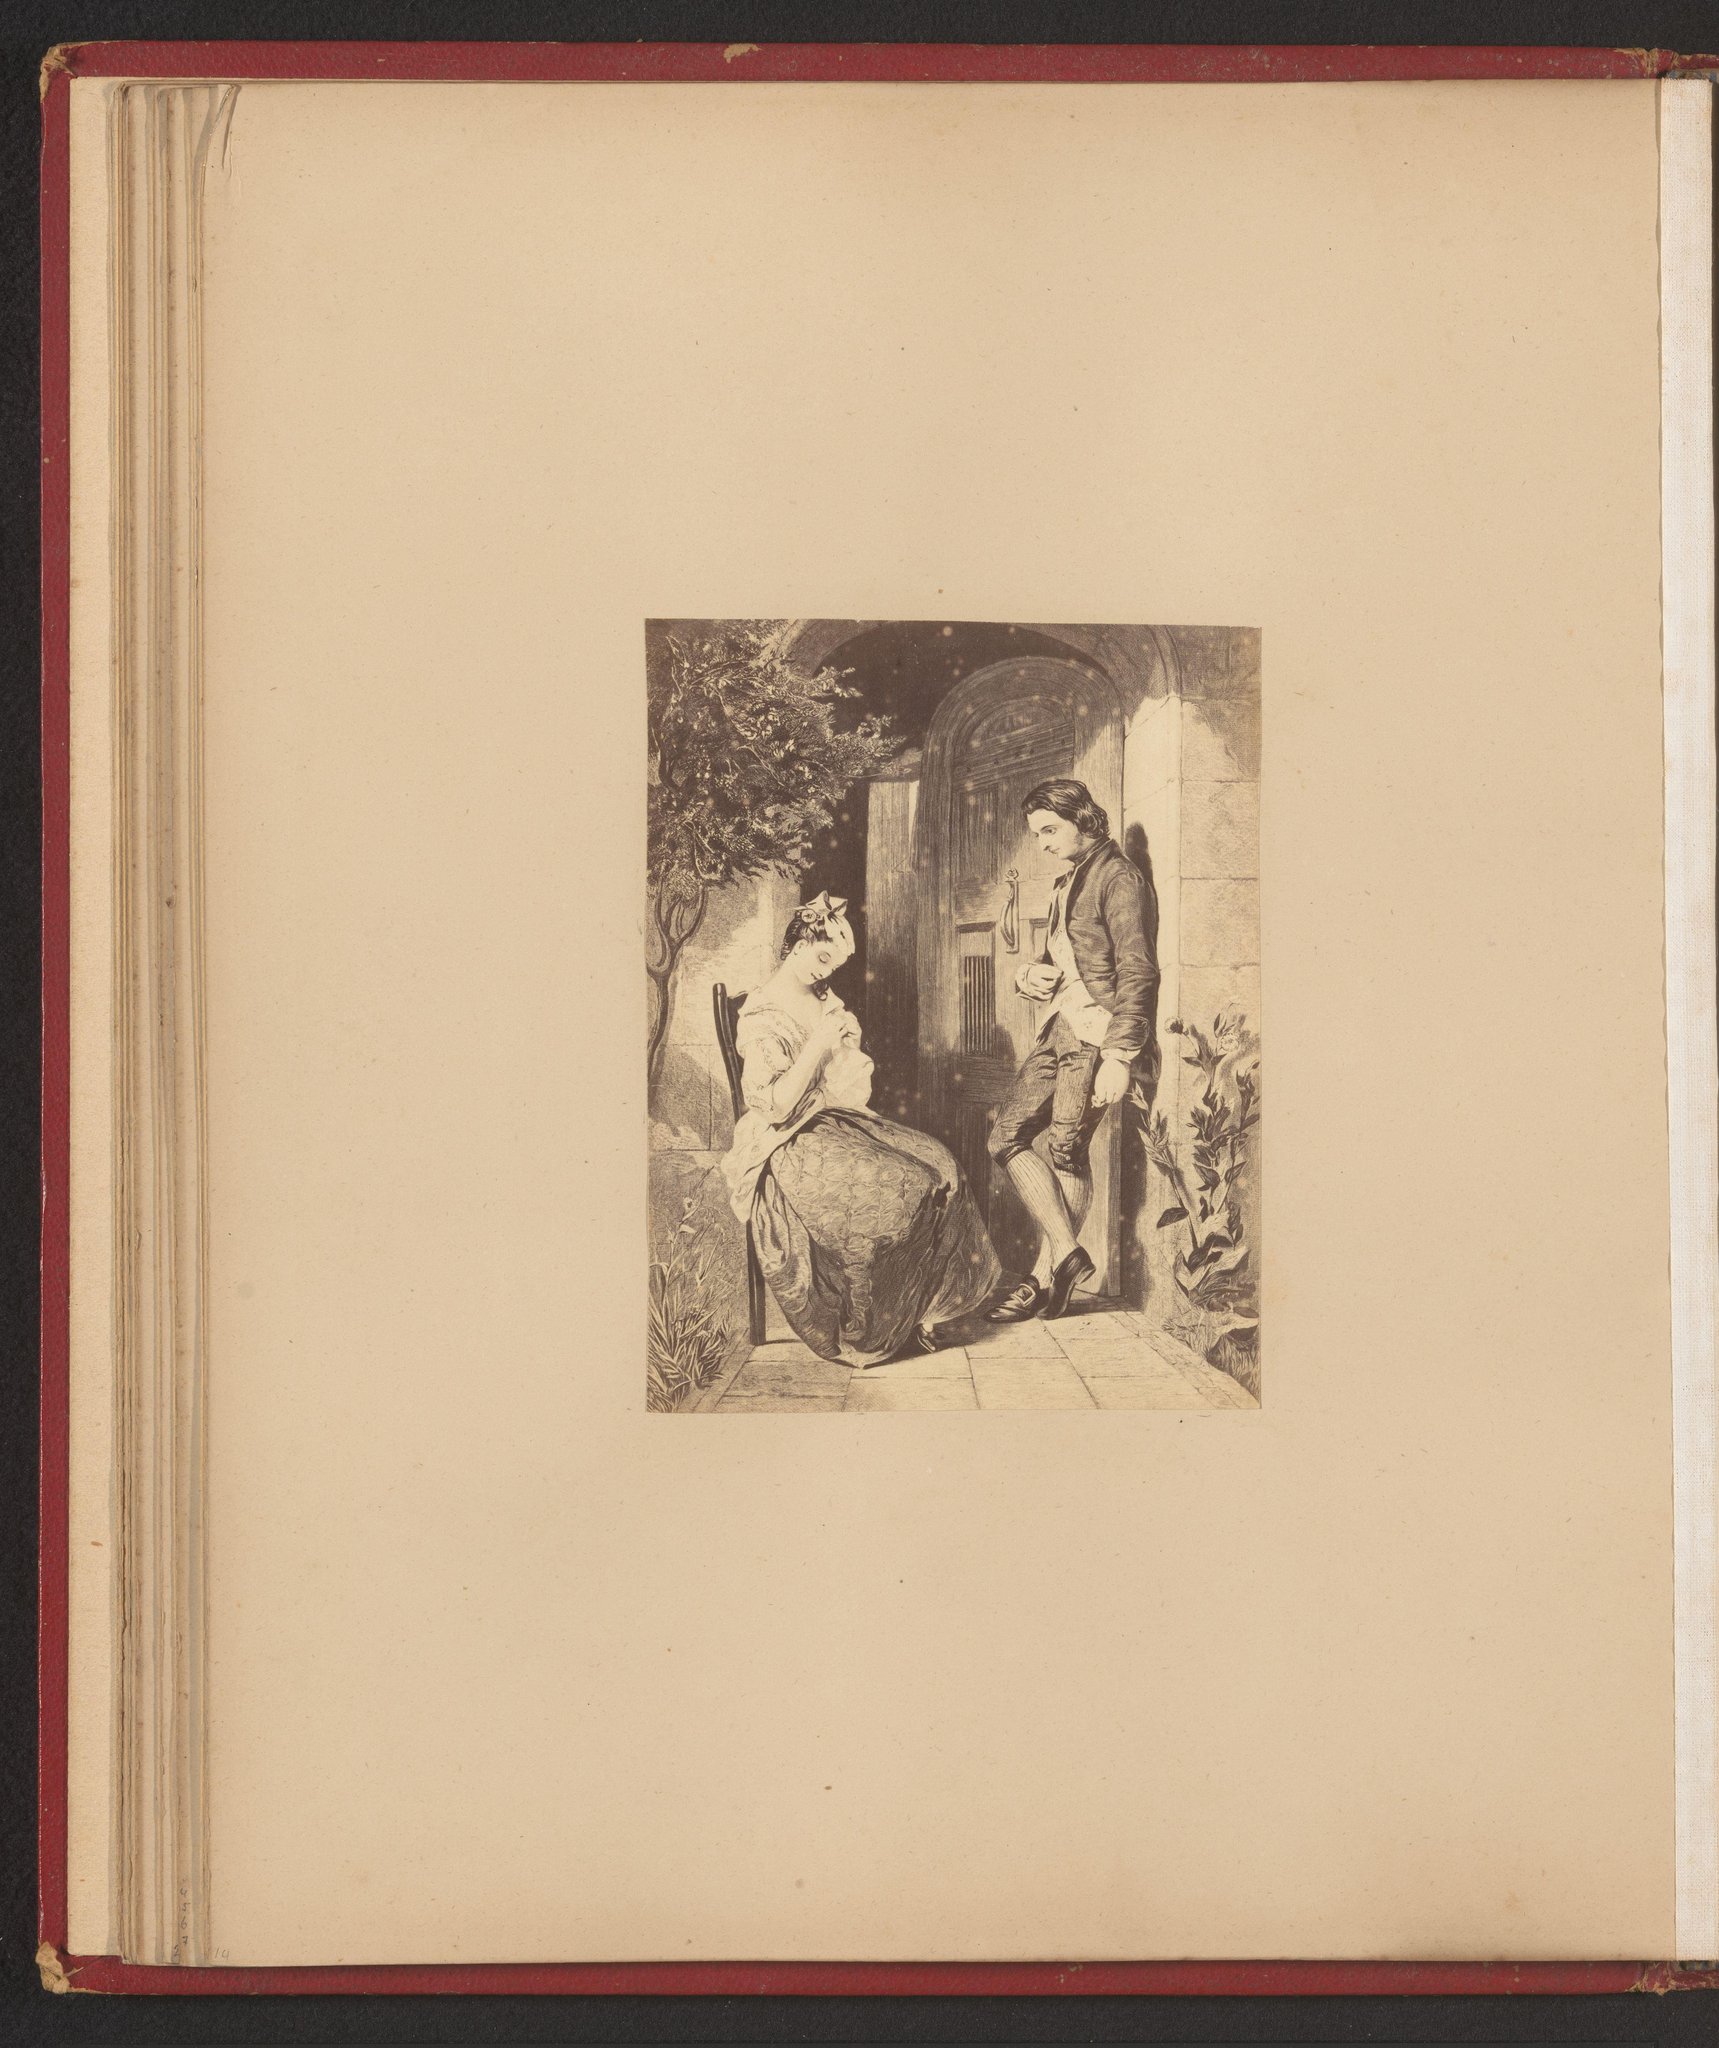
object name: photograph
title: Fotoreproductie van een prent met man en vrouw bij de deur van een woning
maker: Anonymous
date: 1875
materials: photographic support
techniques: albumen print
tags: lovers; courting, flirting